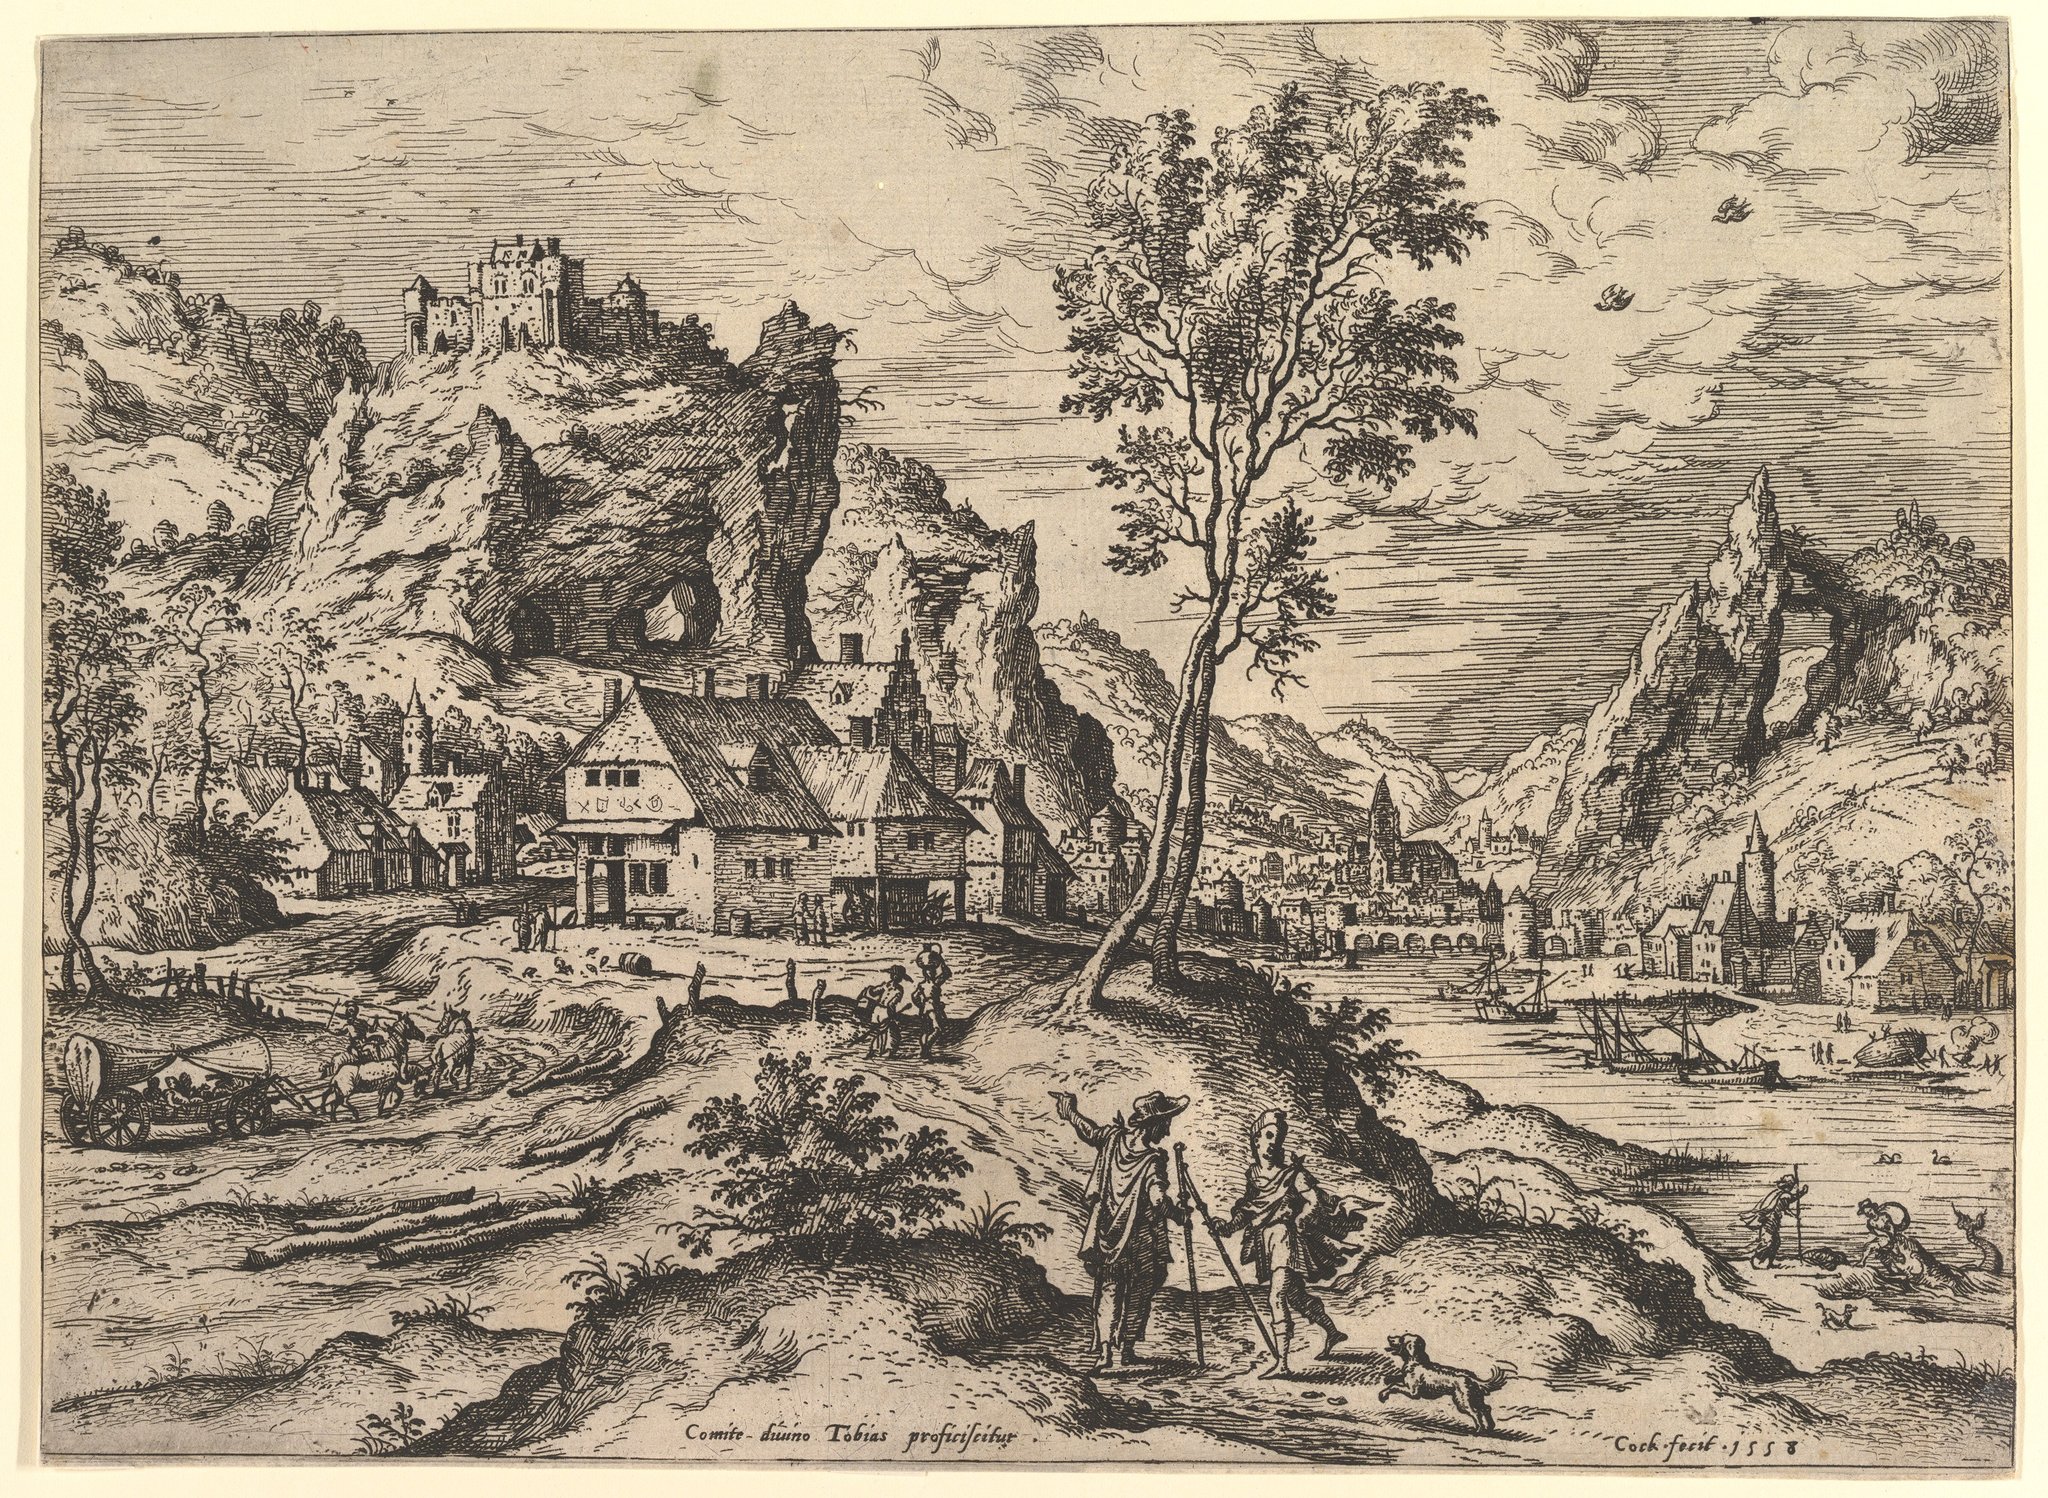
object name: print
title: Tobit, from "Landscapes with Biblical and Mythological Scenes"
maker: hieronymus cock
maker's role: artist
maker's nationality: netherlandish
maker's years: 1510-1570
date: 1558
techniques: etching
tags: buildings,men,hills,landscapes,trees